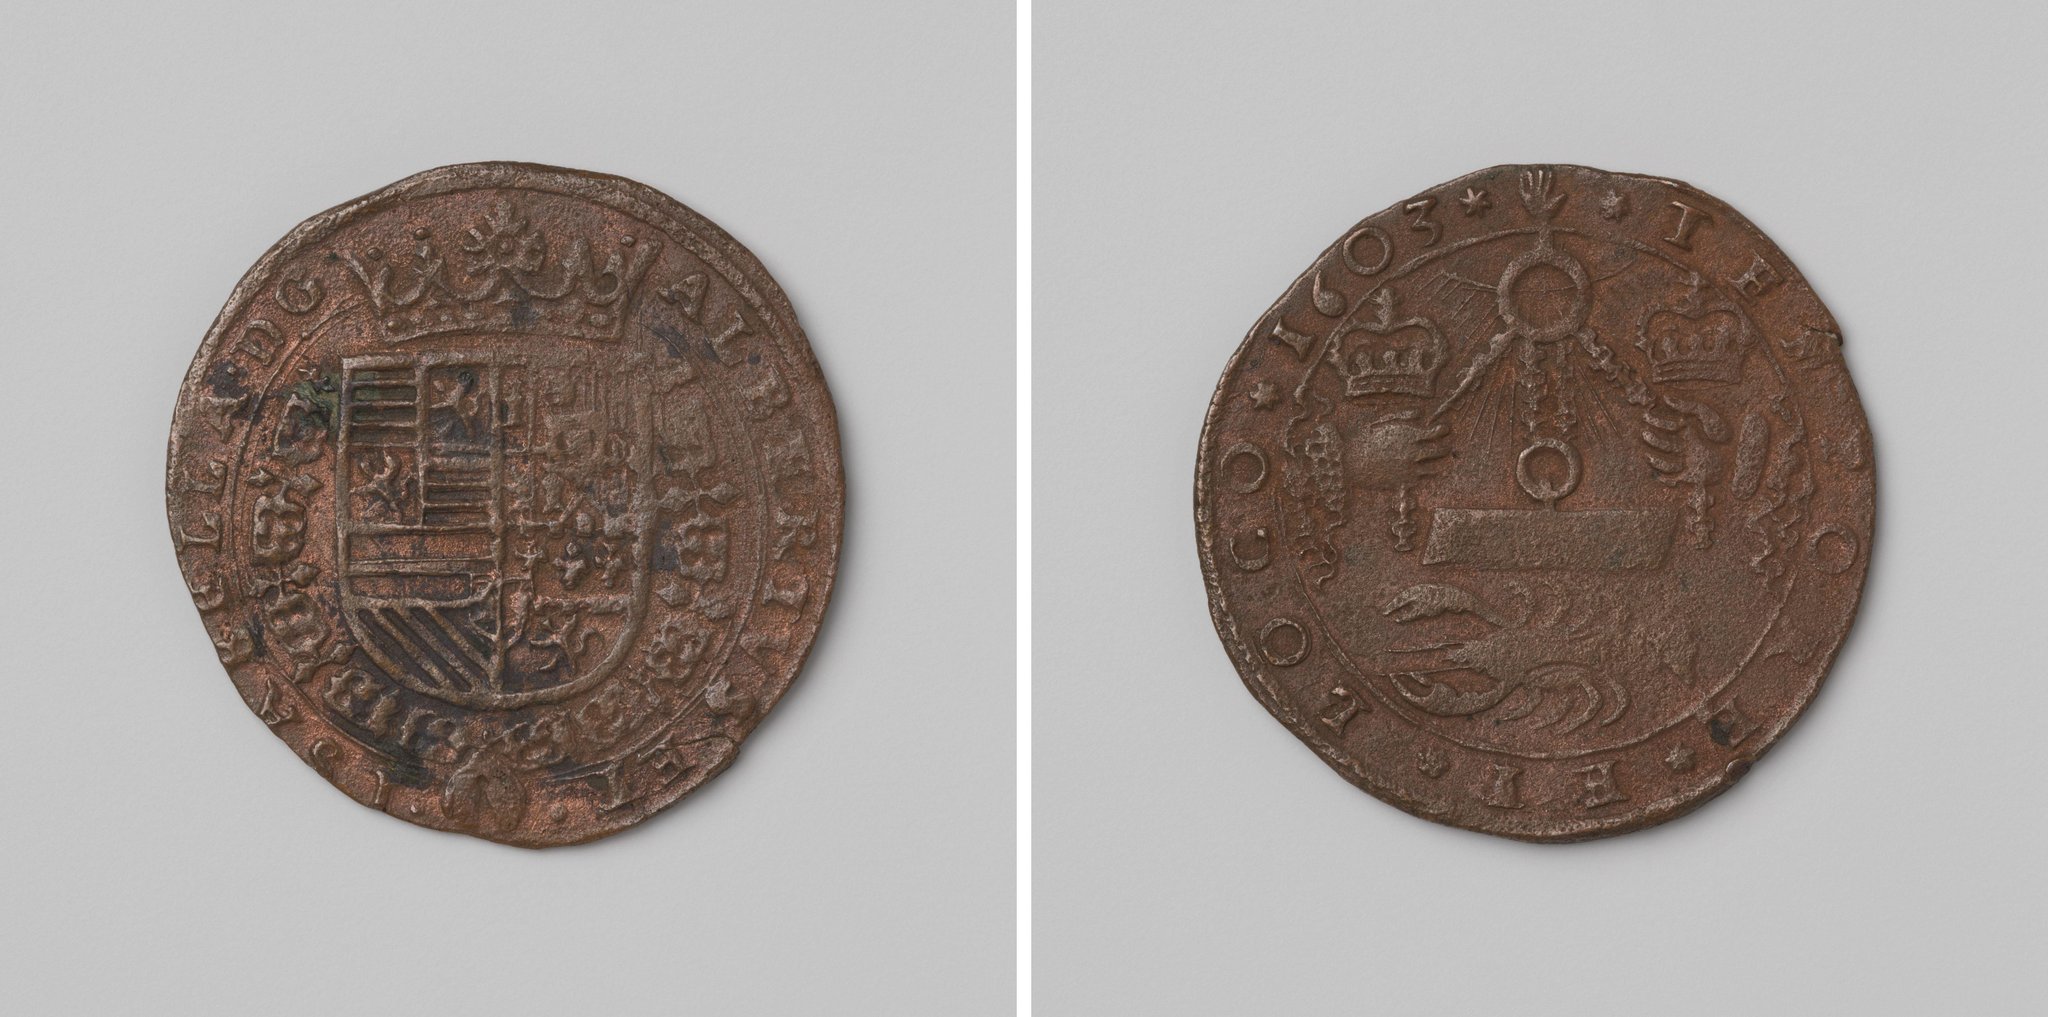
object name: jeton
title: Voortduren van het beleg van Oostende, rekenpenning ter ere van Albrecht en Isabella van Oostenrijk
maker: Anonymous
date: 1603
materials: copper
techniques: striking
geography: antwerp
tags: infante van spanje isabella clara eugenia, brussels, albrecht aartshertog van oostenrijk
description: Koperen penning. Voorzijde: gekroond wapenschild, omhangen met de orde van het Gulden Vlies binnen omschrift. Keerzijde: twee handen, elk onder kroon proberen met heiblok kreeft te vermorzelen binnen omschrift